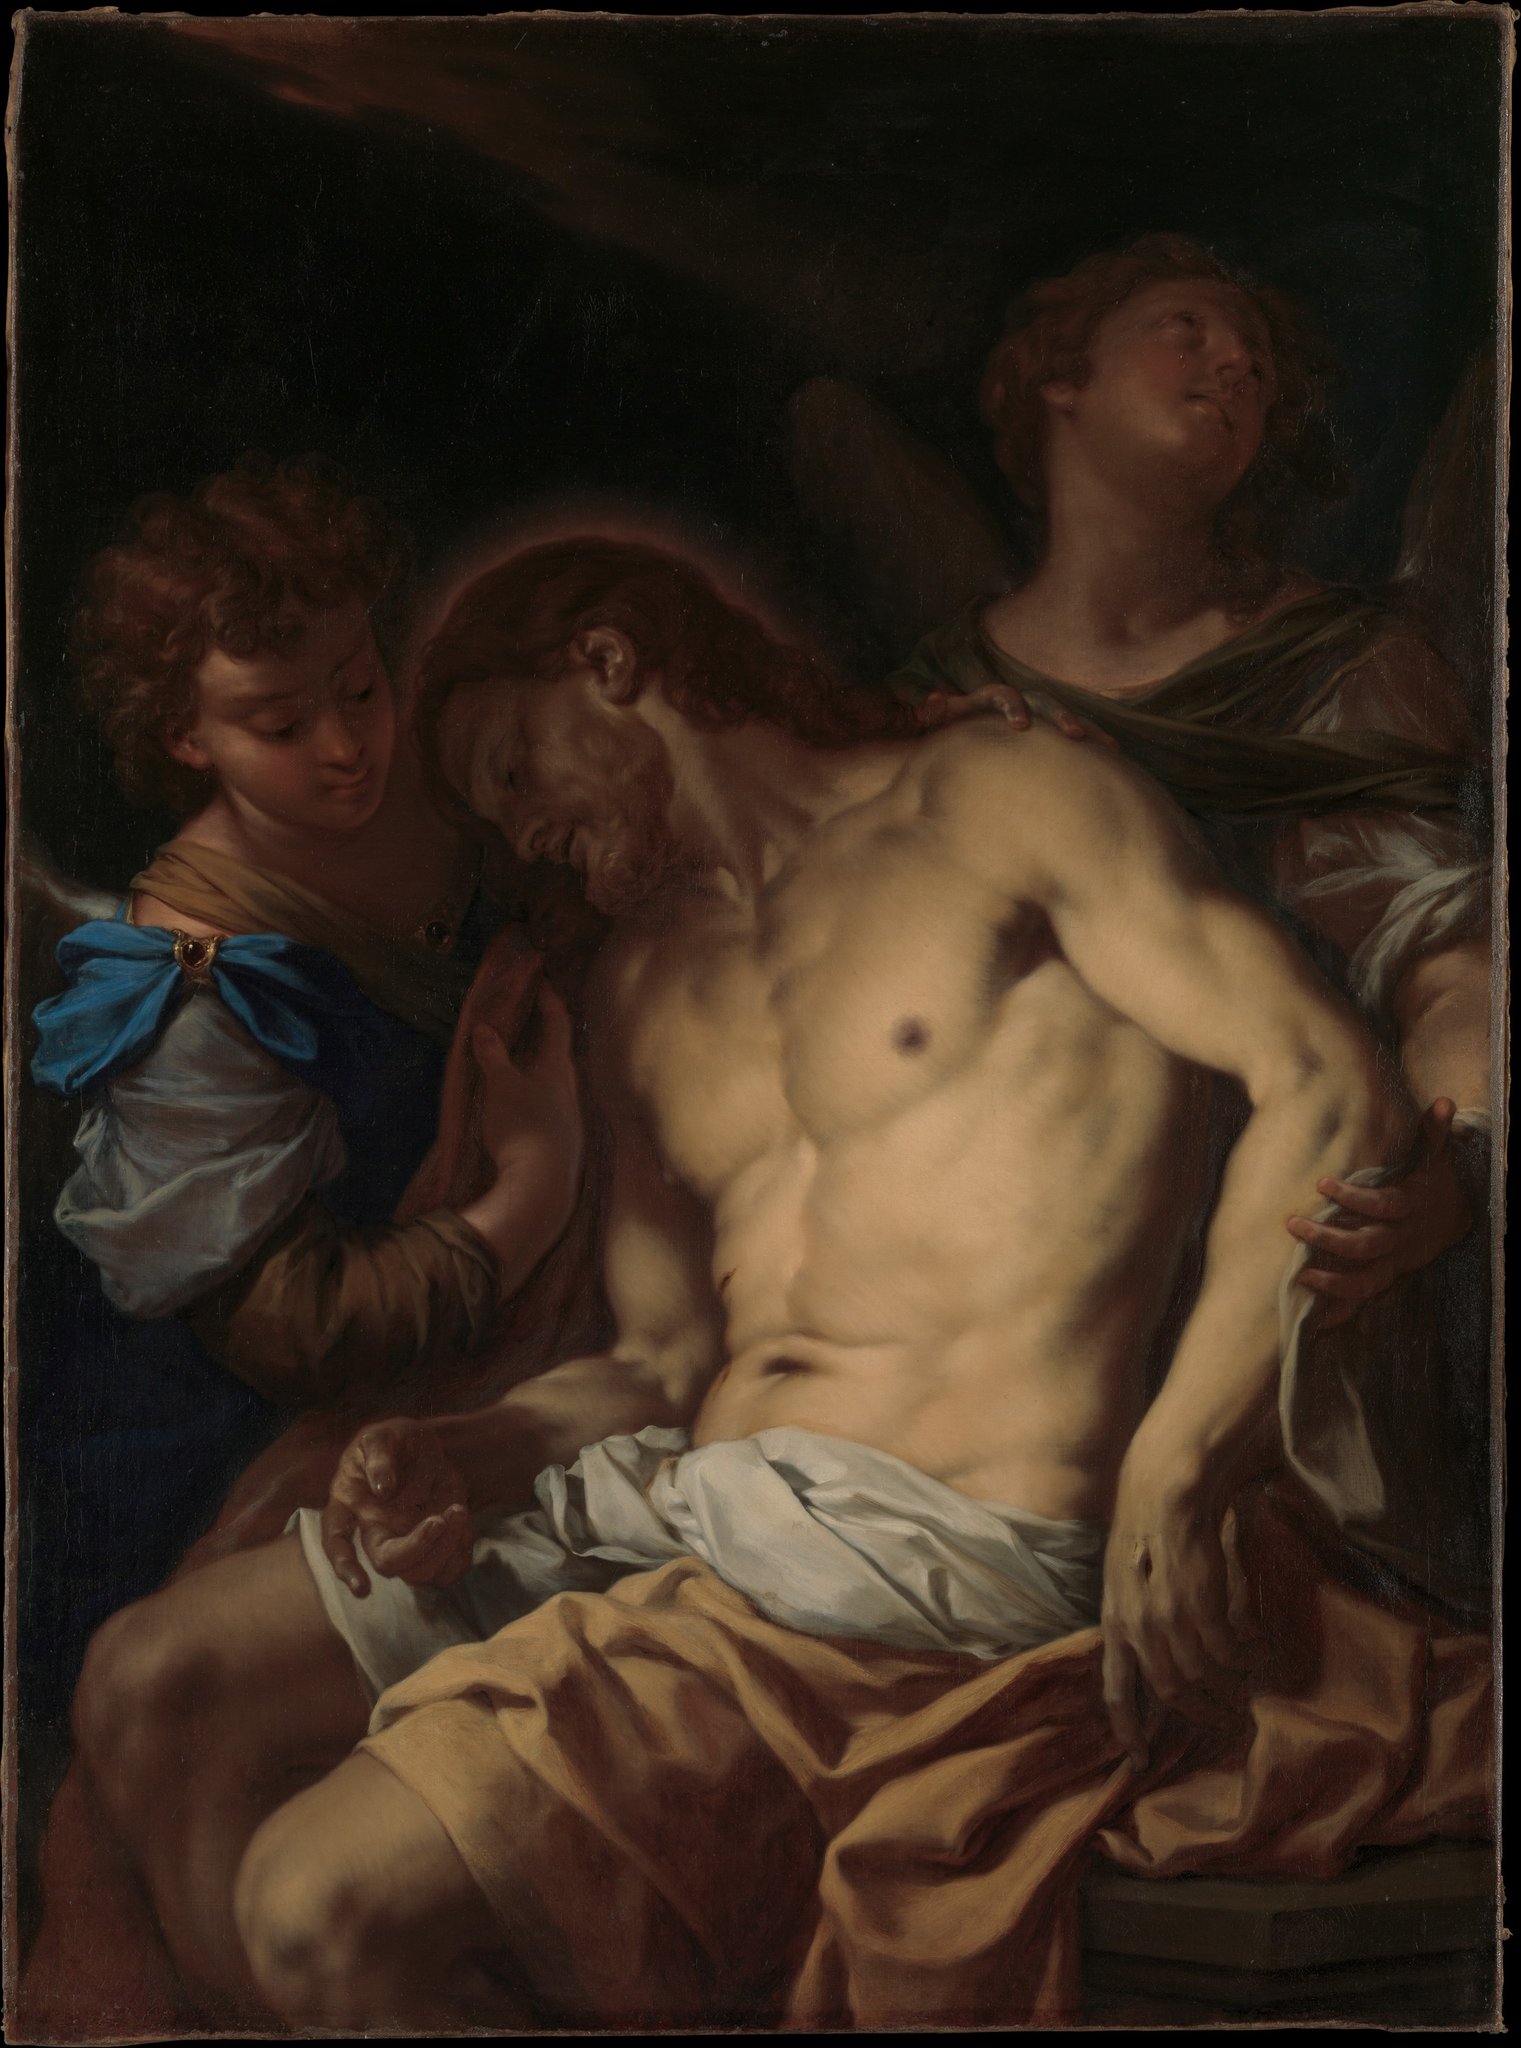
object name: painting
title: Dead Christ Supported by Angels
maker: francesco trevisani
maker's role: artist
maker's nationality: italian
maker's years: 1656-1746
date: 1710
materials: canvas, oil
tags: angels,christ